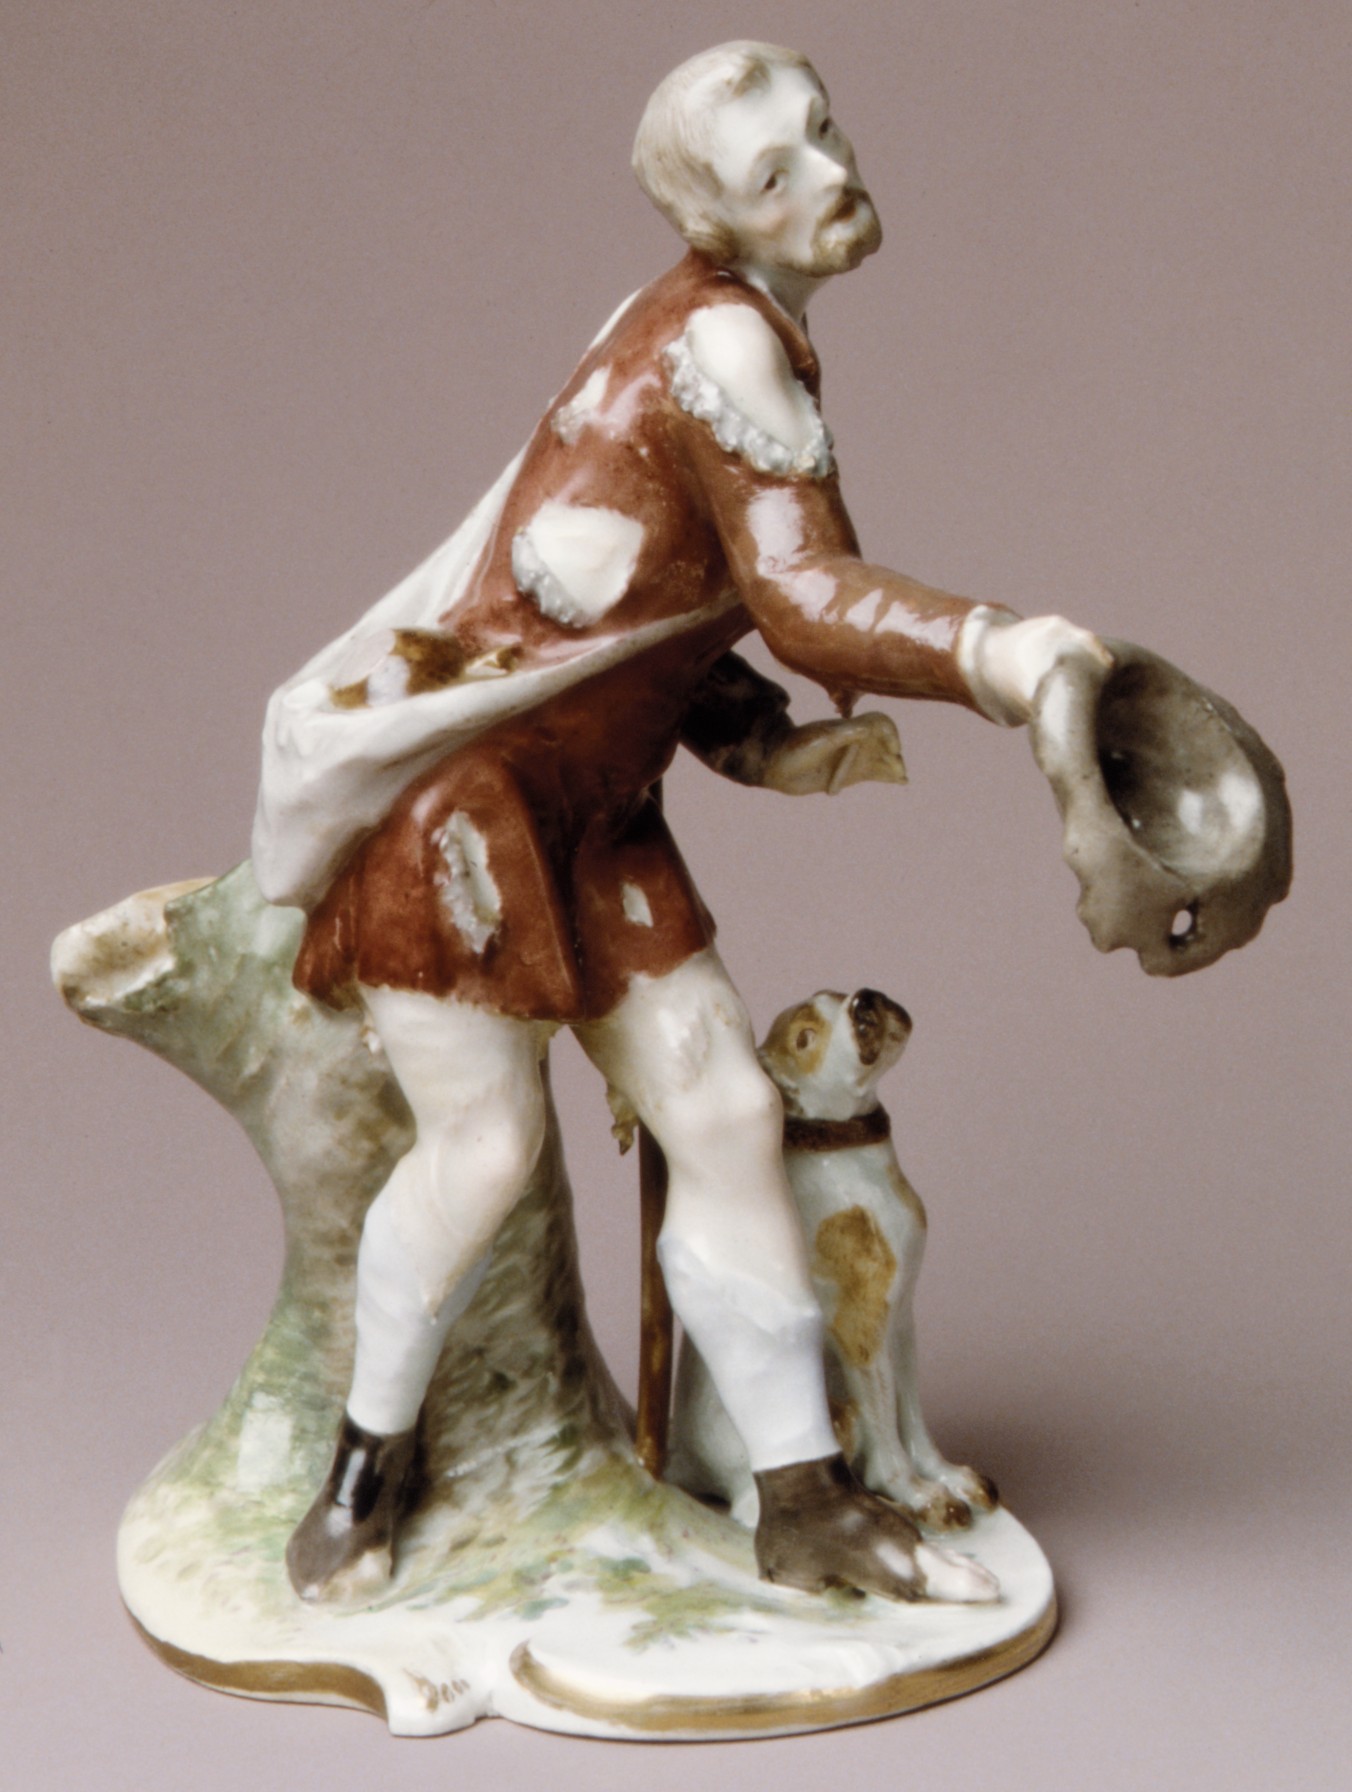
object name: figure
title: Beggar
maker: nymphenburg porcelain manufactory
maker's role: manufactory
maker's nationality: german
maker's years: 1747-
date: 1760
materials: hard paste porcelain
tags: men,dogs